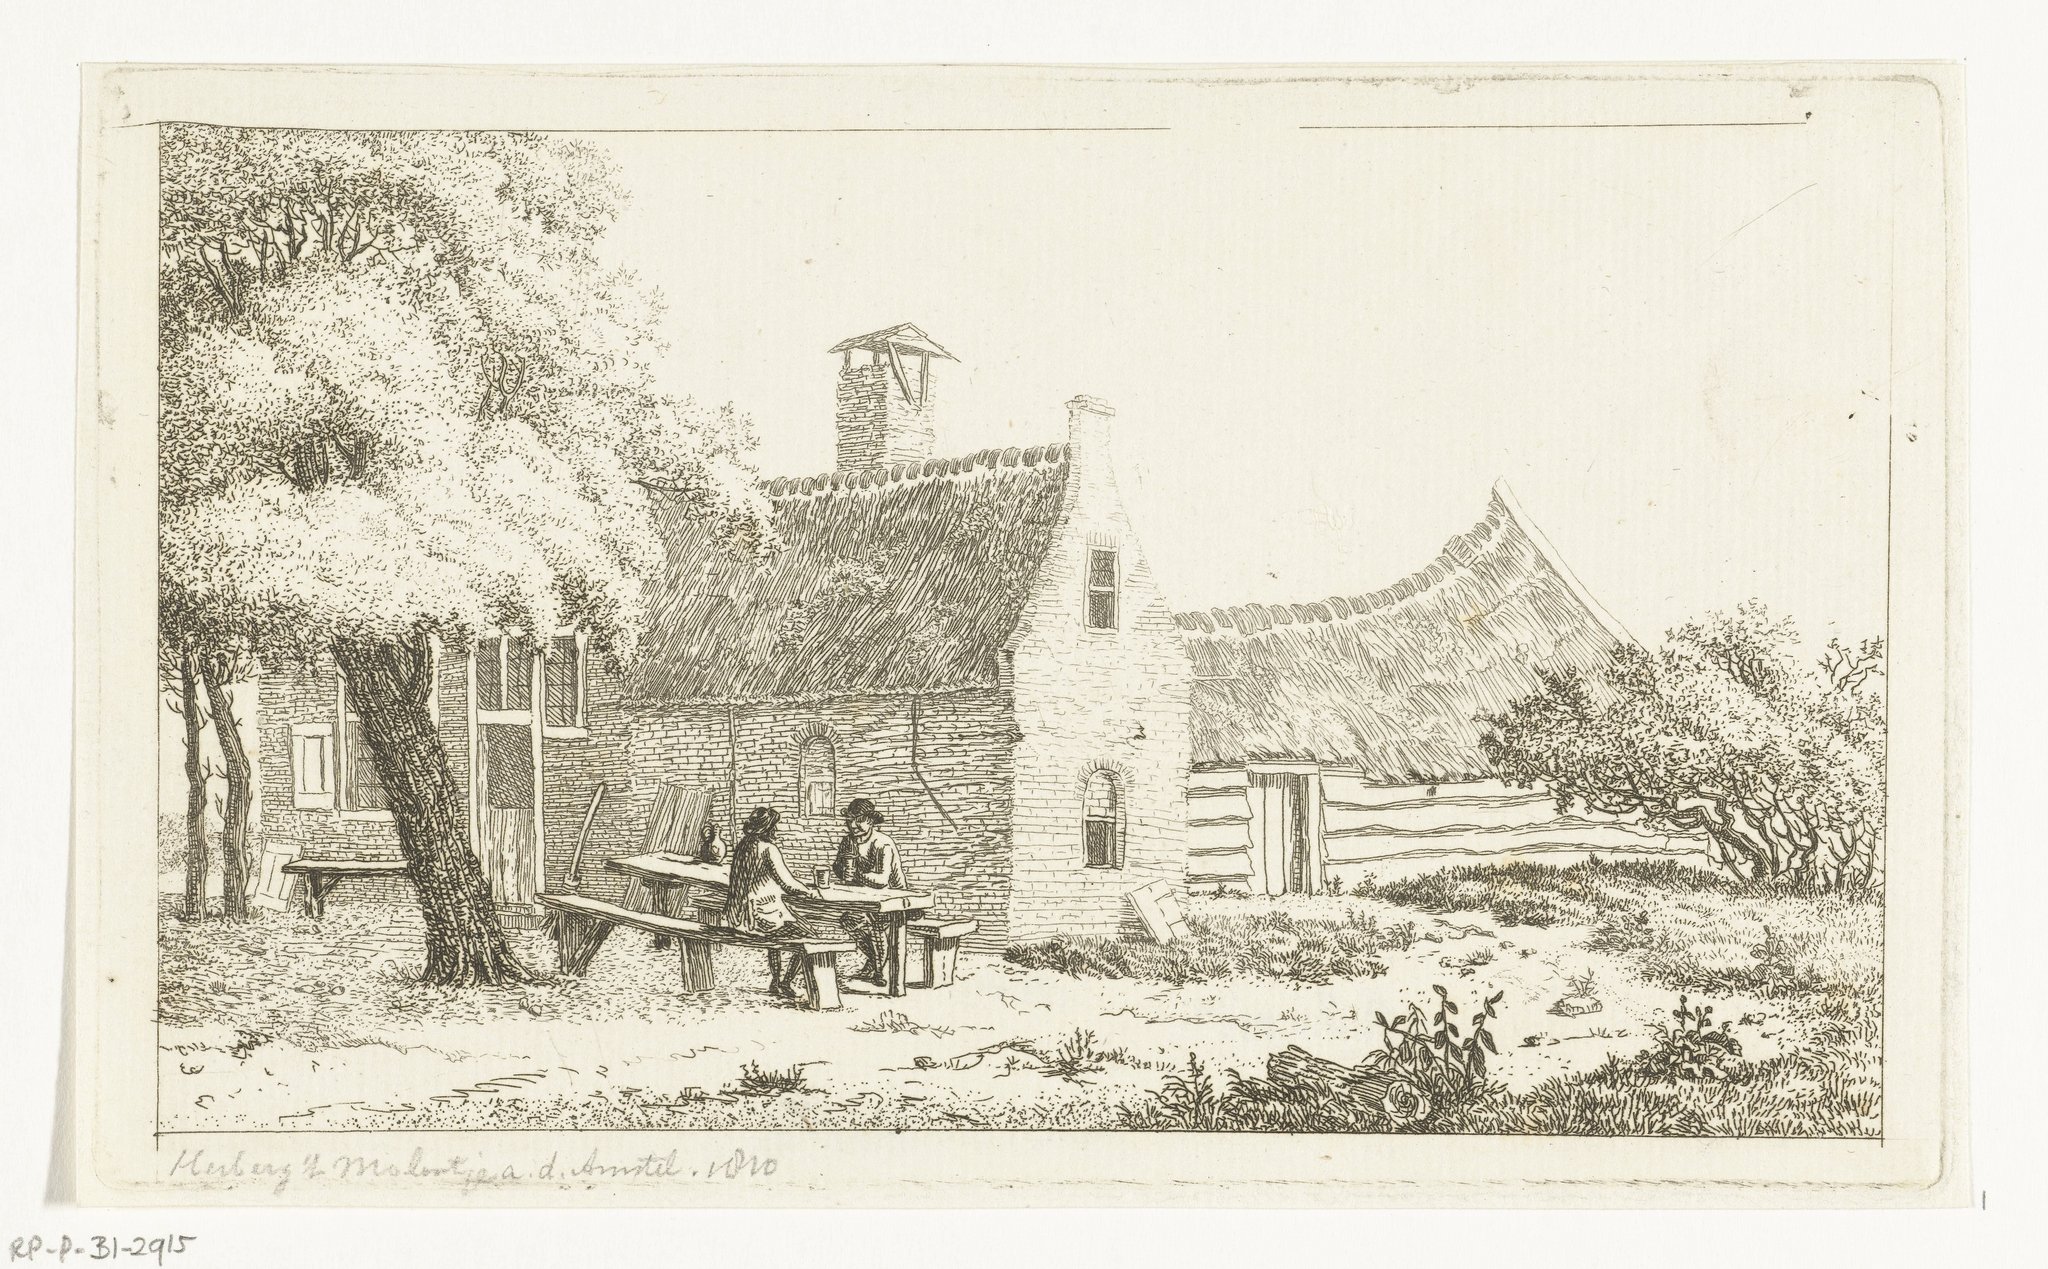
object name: print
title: Twee mannen aan een tafel voor herberg het Molentje aan de Amstel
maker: anthonie van den bos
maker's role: draughtsman, print maker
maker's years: 1763-1838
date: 1810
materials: paper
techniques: etching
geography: netherlands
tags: inn, coffee-house, public house, etc.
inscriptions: collector's mark: Lugt 2228